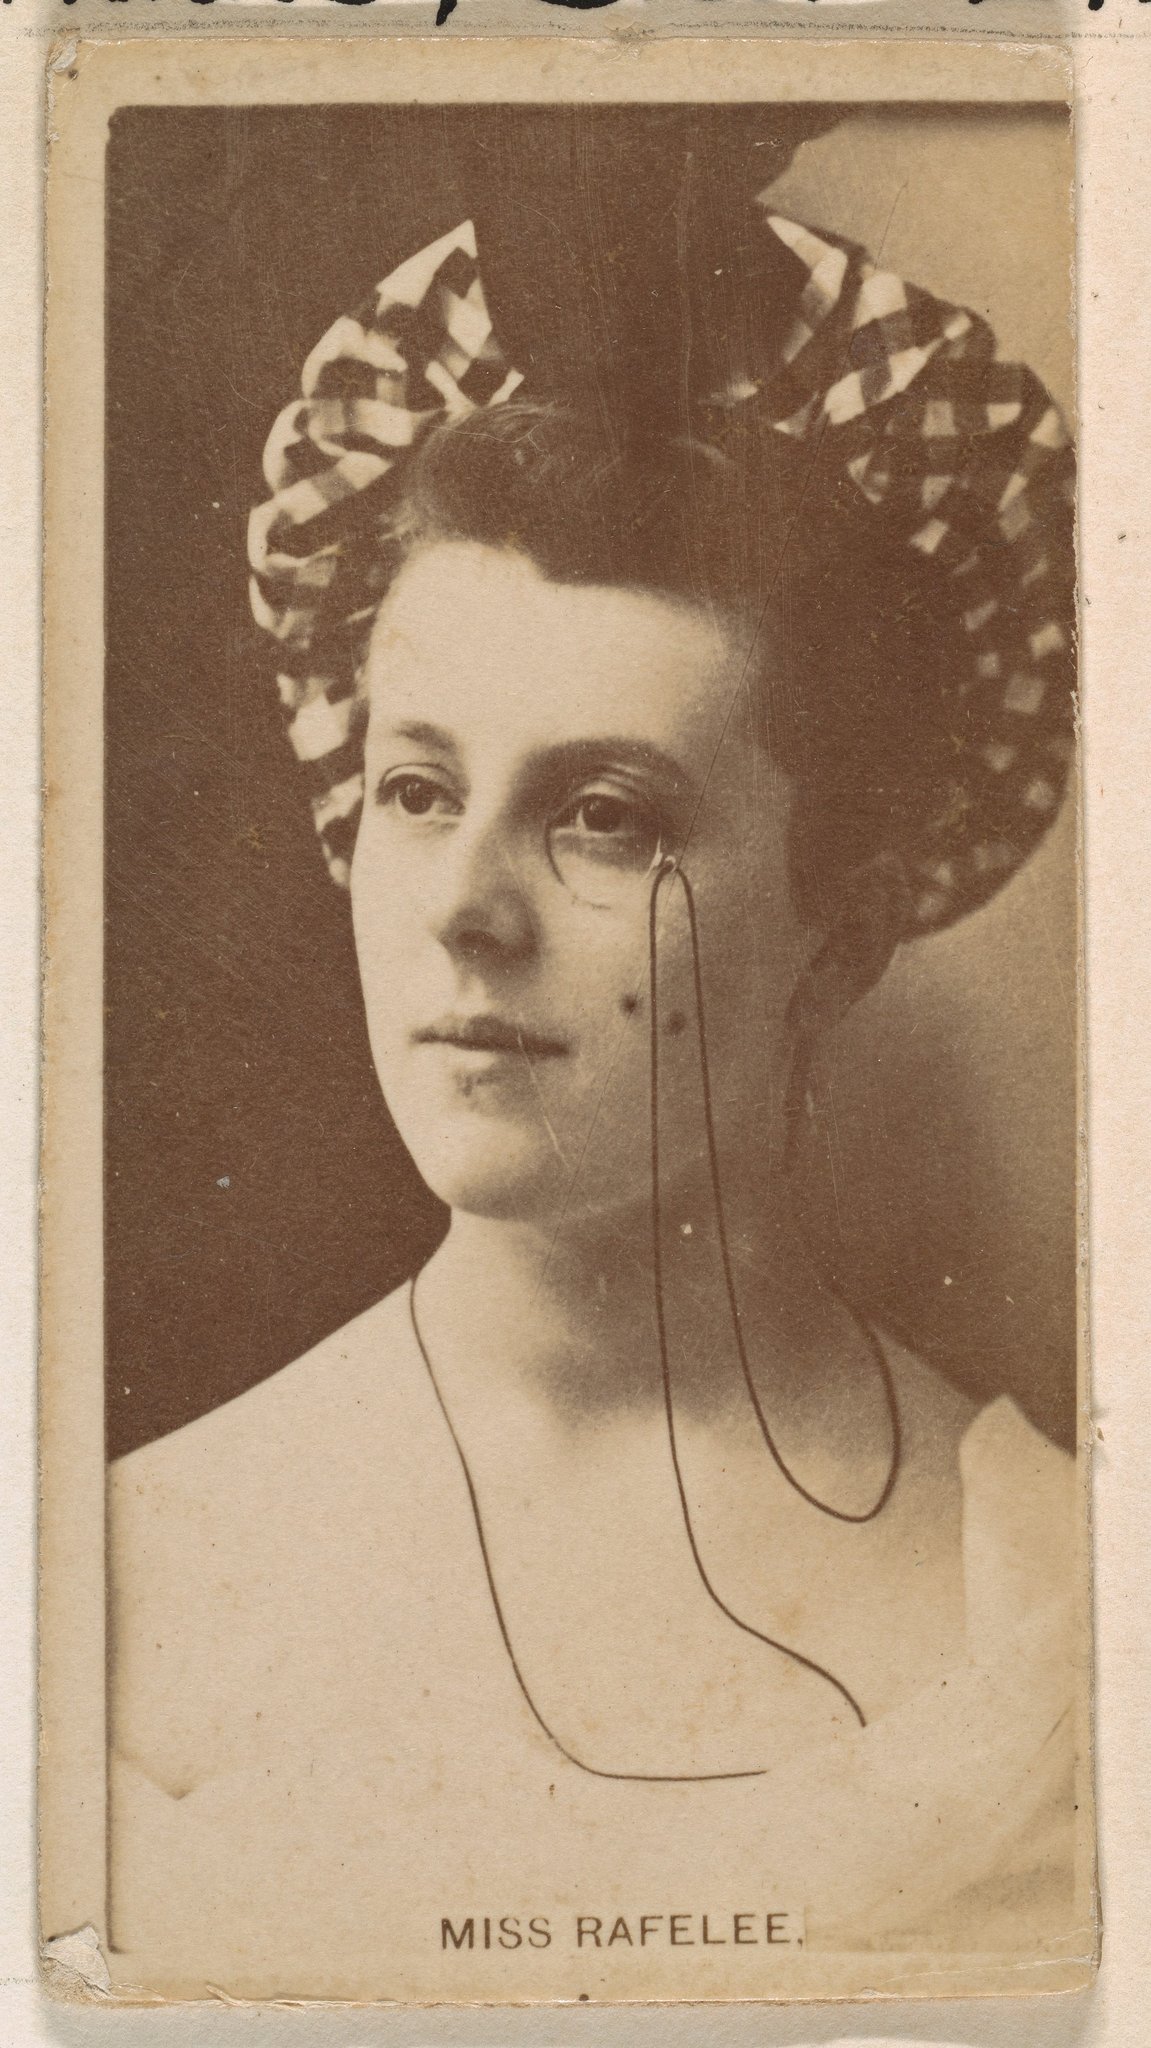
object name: photograph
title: Miss Rafelee, from the Actresses series (N245) issued by Kinney Brothers to promote Sweet Caporal Cigarettes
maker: kinney brothers tobacco company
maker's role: publisher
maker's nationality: american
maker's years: 1869-2011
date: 1890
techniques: albumen silver print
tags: portraits,women,actresses